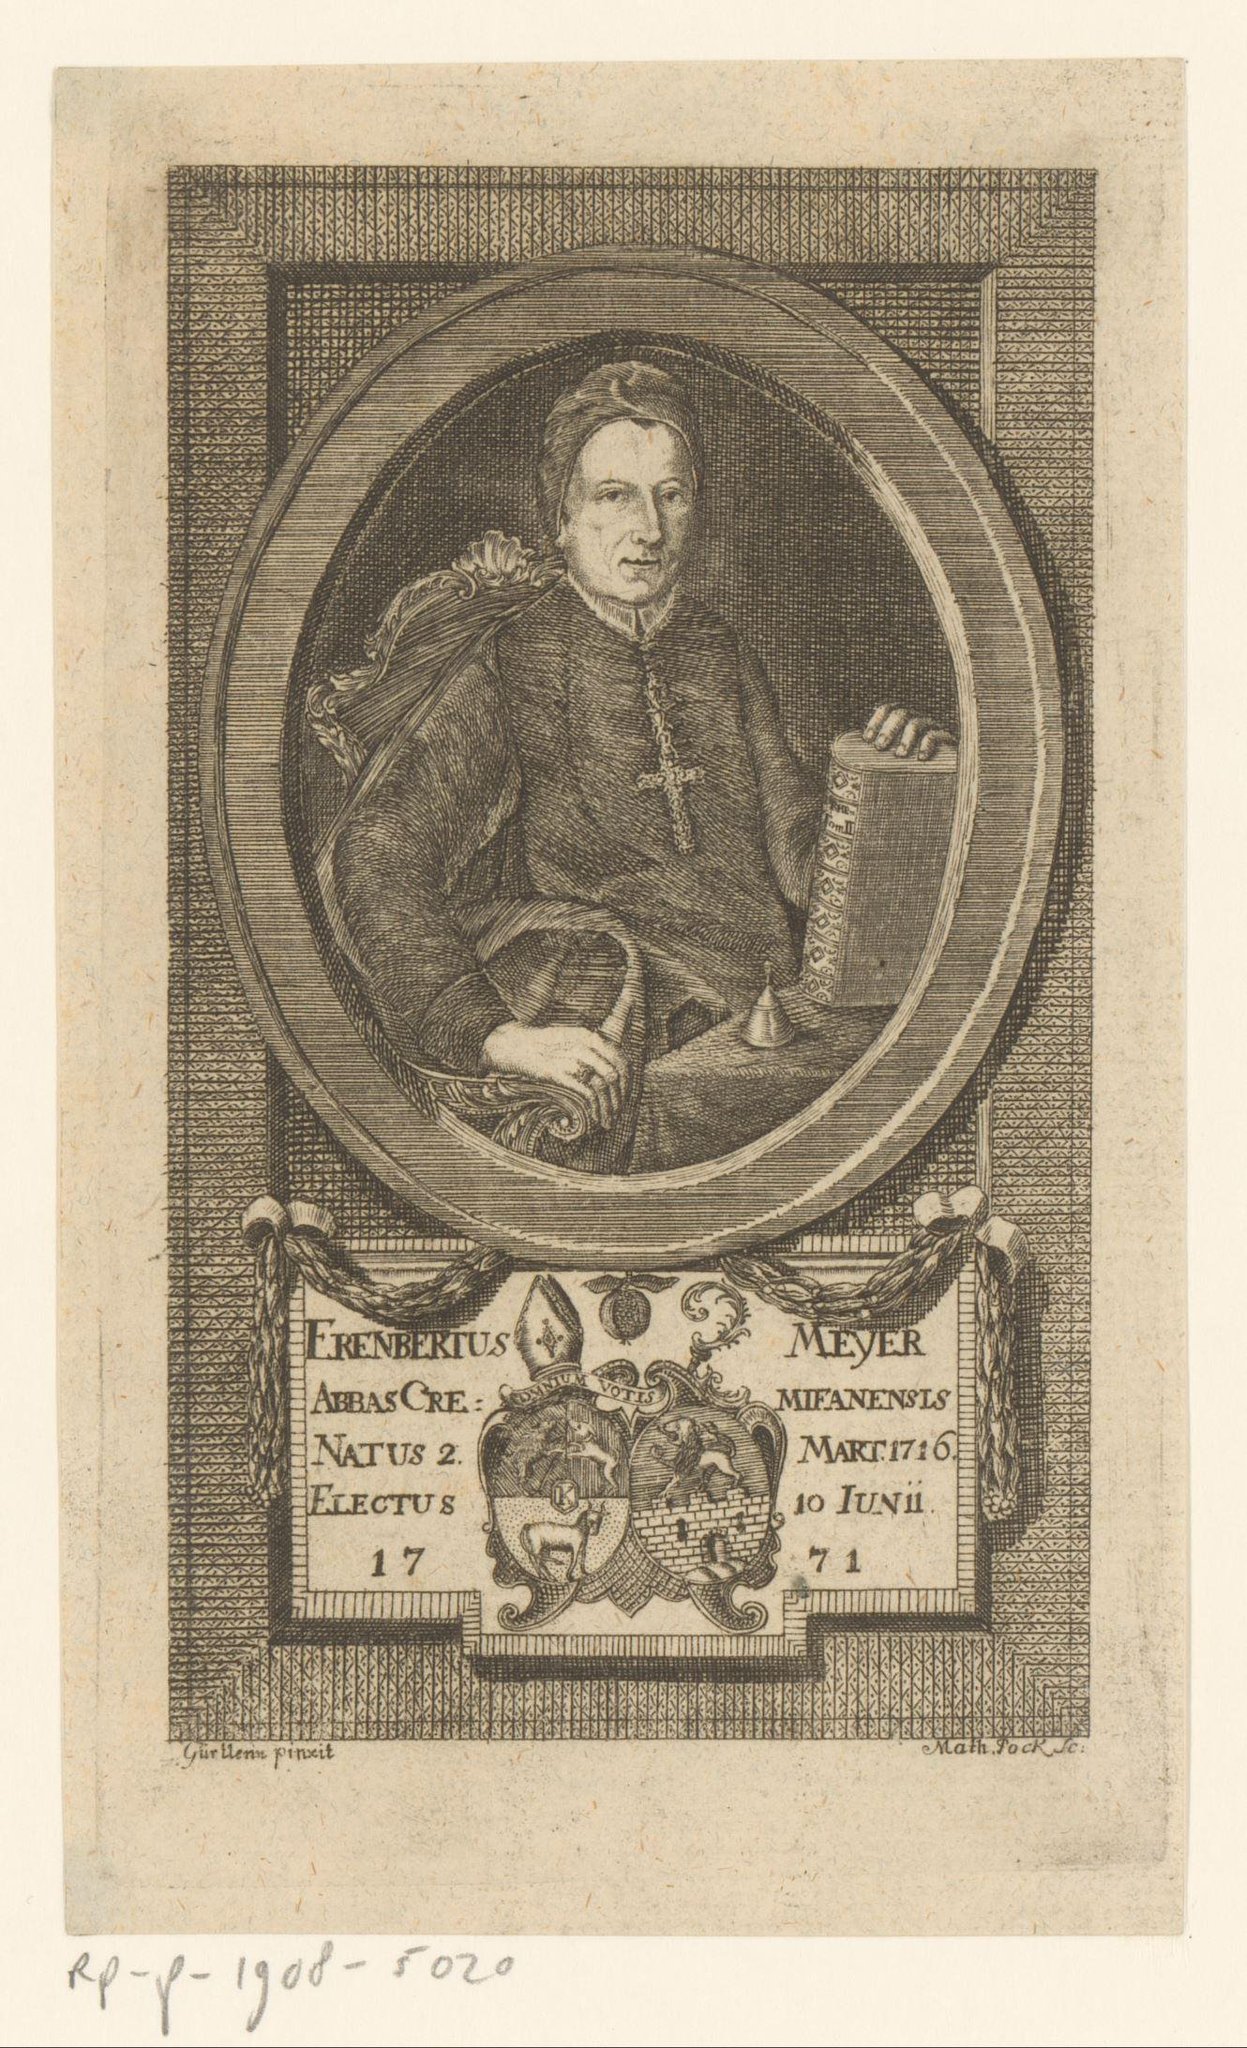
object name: print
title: Portret van Erenbertus Meyer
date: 1729-1795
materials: paper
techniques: engraving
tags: historical persons, book, crucifix ~ personal devotion, armorial bearing, heraldry, bell ~ acoustic signalling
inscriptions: collector's mark: Lugt 2228